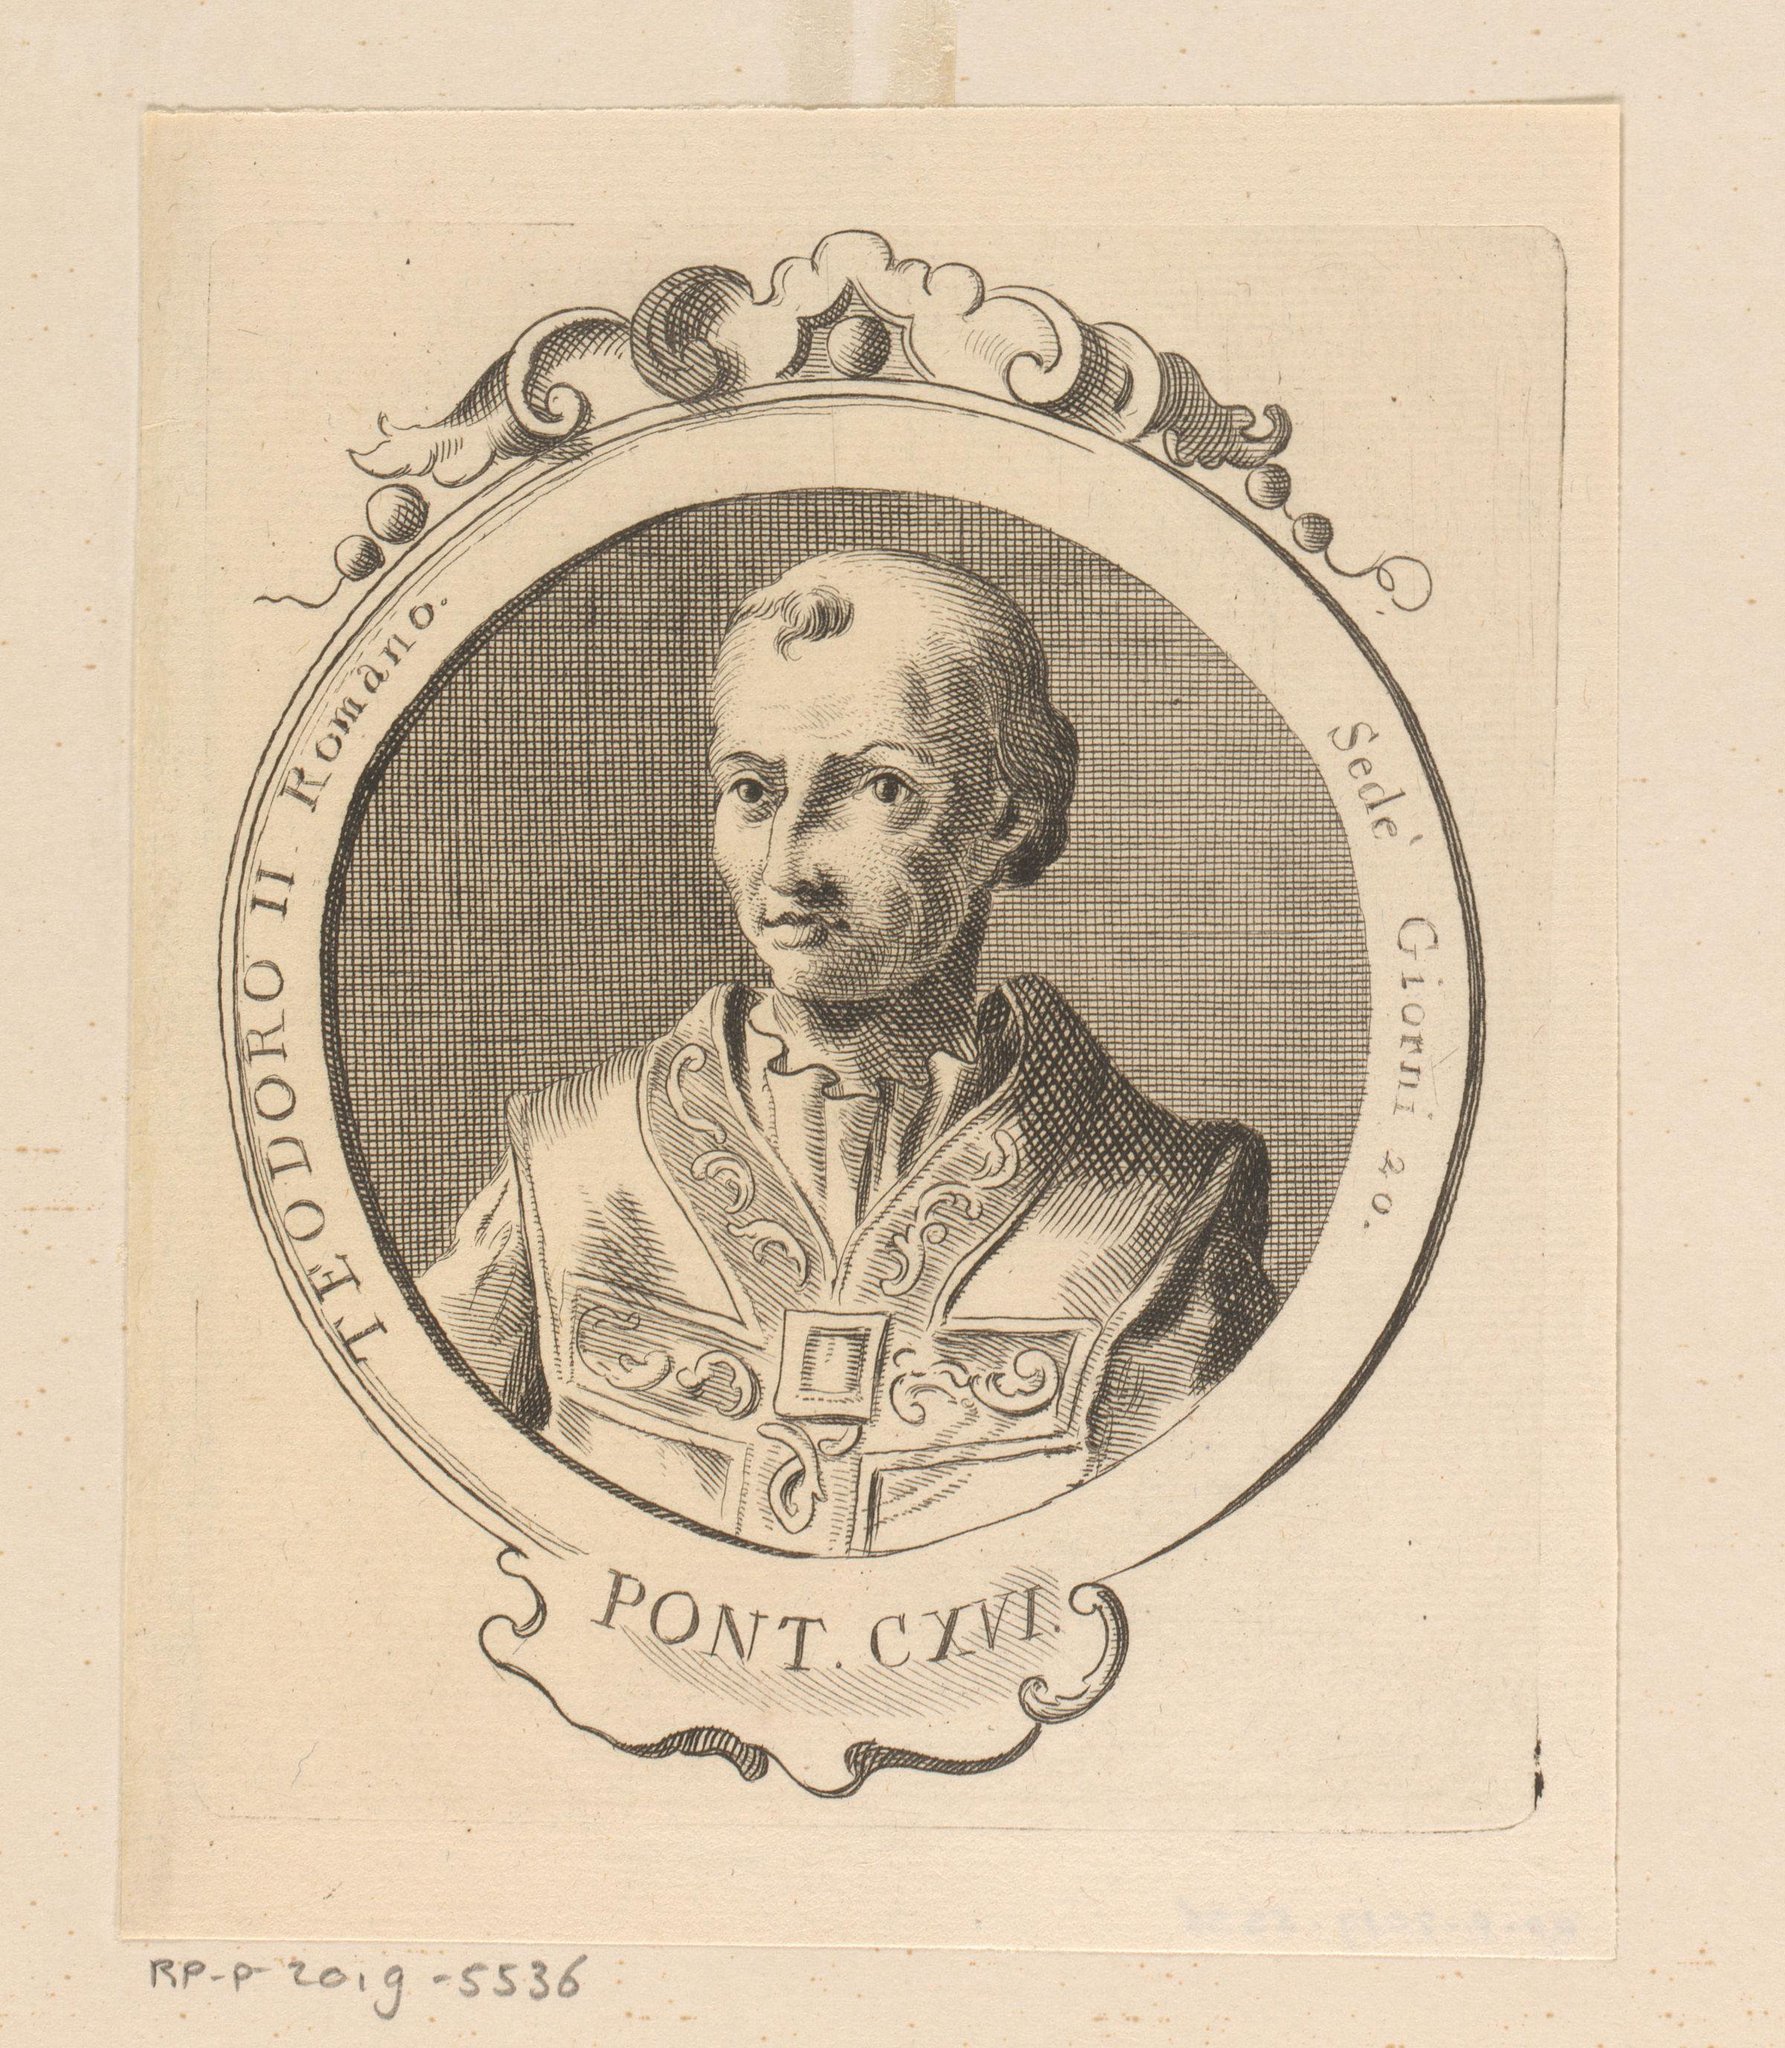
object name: print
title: Teodoro II Romano.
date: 1775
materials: paper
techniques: etching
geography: venice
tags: rome, historical persons, pope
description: Prent uit: Effigies Romanorum pontificum a S. Petro ad Pium VI. feliciter regnantem (...). 2 dln. Venetië en Bassano del Grappa: Giuseppe Remondini, 1775.